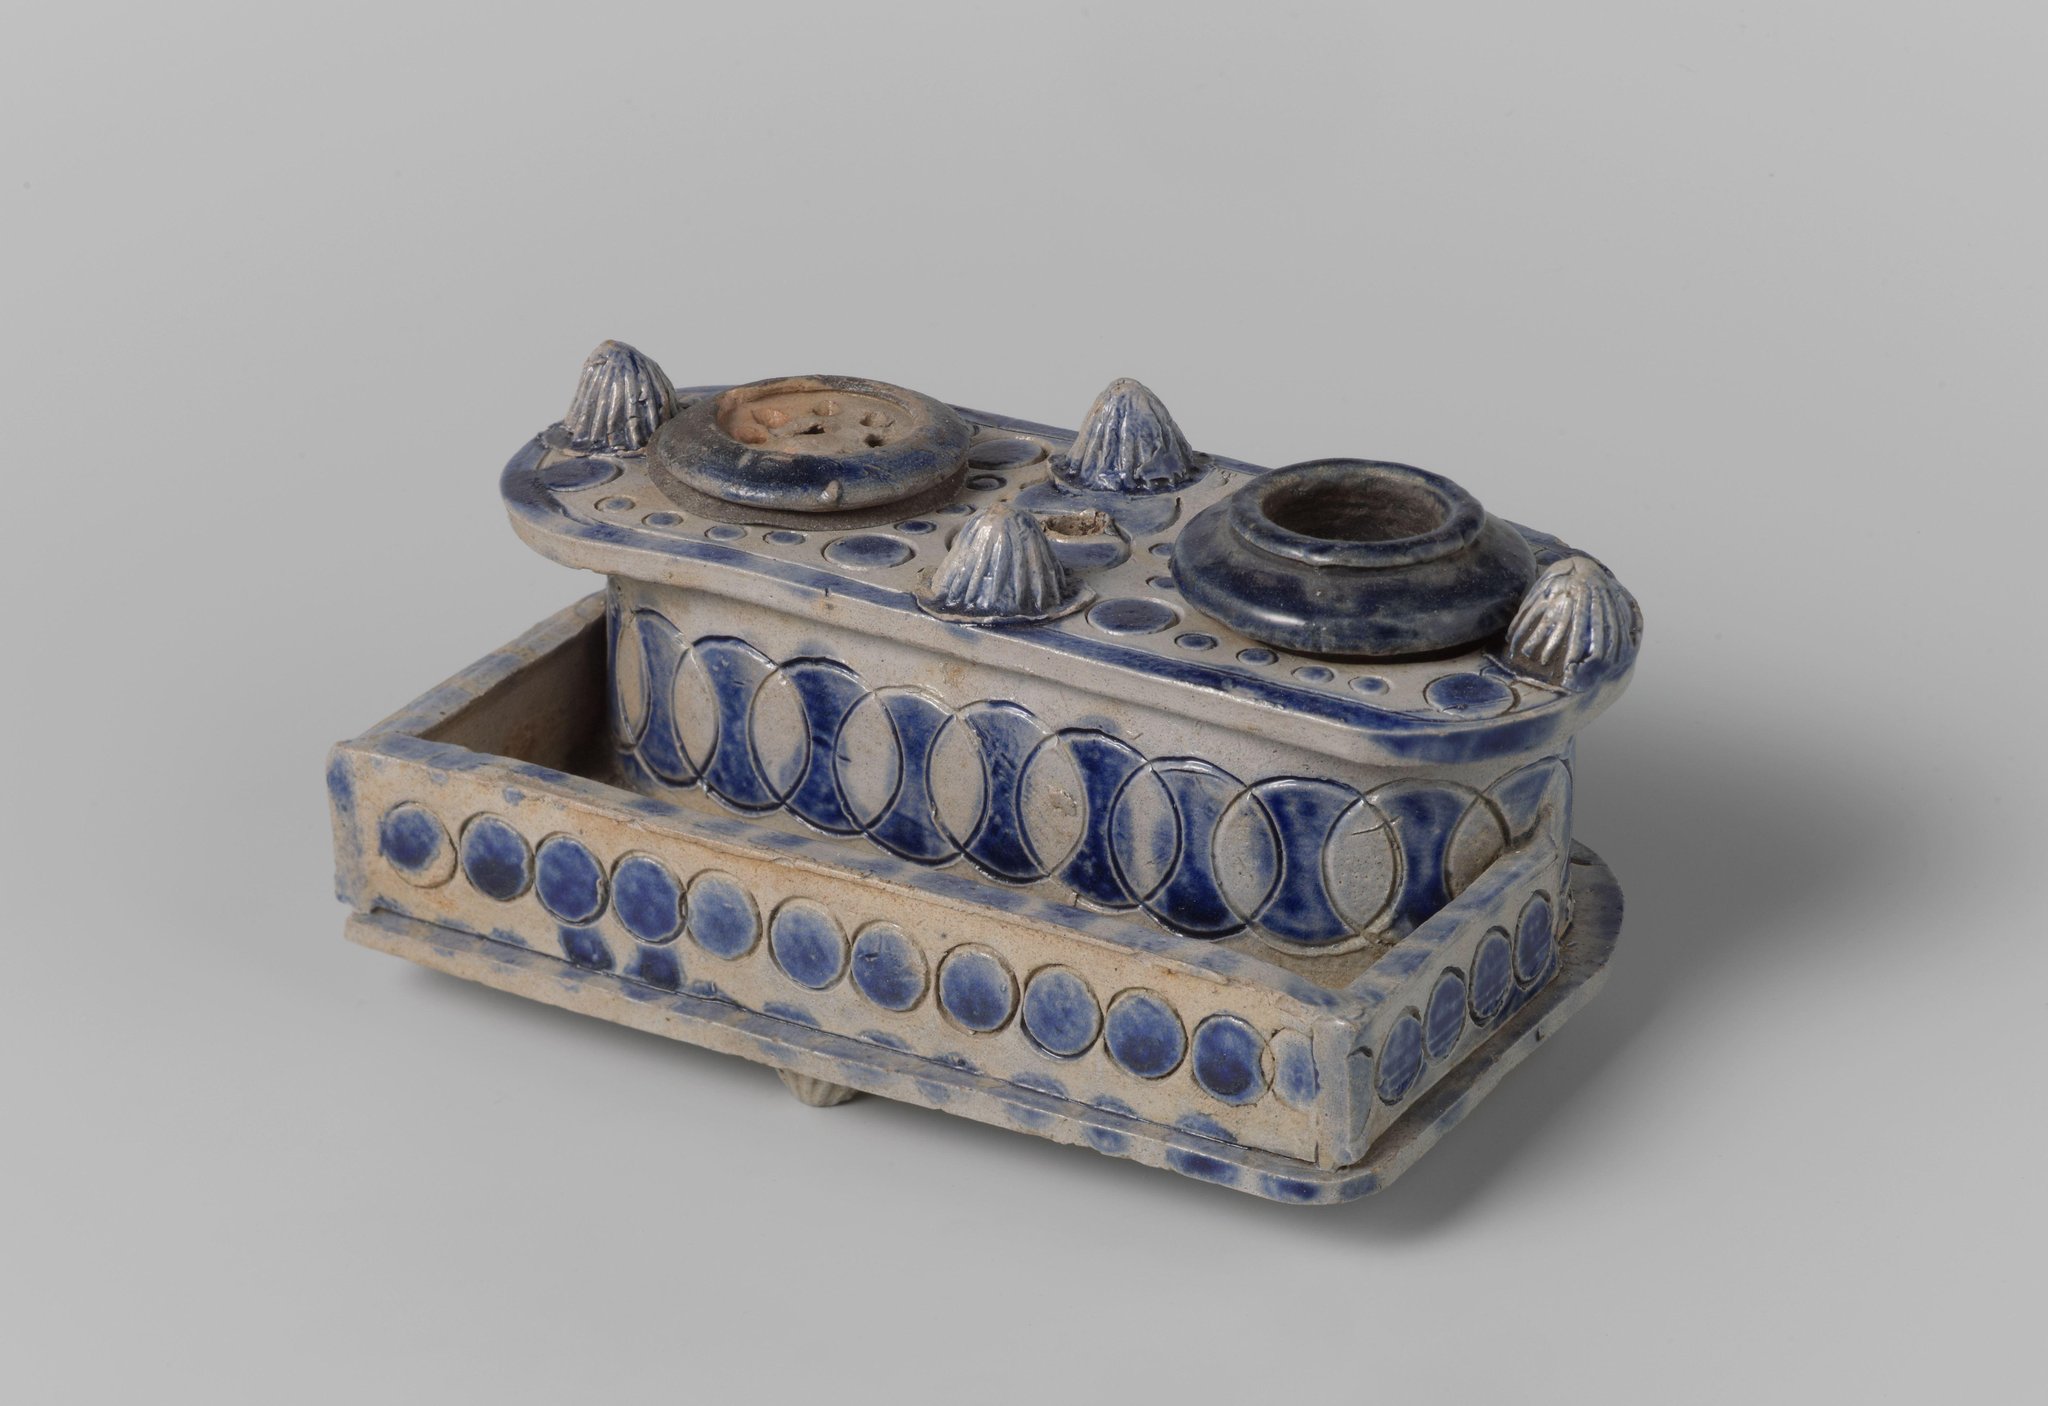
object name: sander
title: Sand shaker with pierced top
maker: Anonymous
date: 1750-1799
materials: cobalt, glaze, stoneware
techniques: embroidery, firing, turning, vitrification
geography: westerwald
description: Zandstrooier van steengoed met een cilindrisch lichaam, uitlopende rand om in de houder te plaatsen en opengewerkte bovenzijde. De rand is bedekt met kobaltblauw. Westerwald.